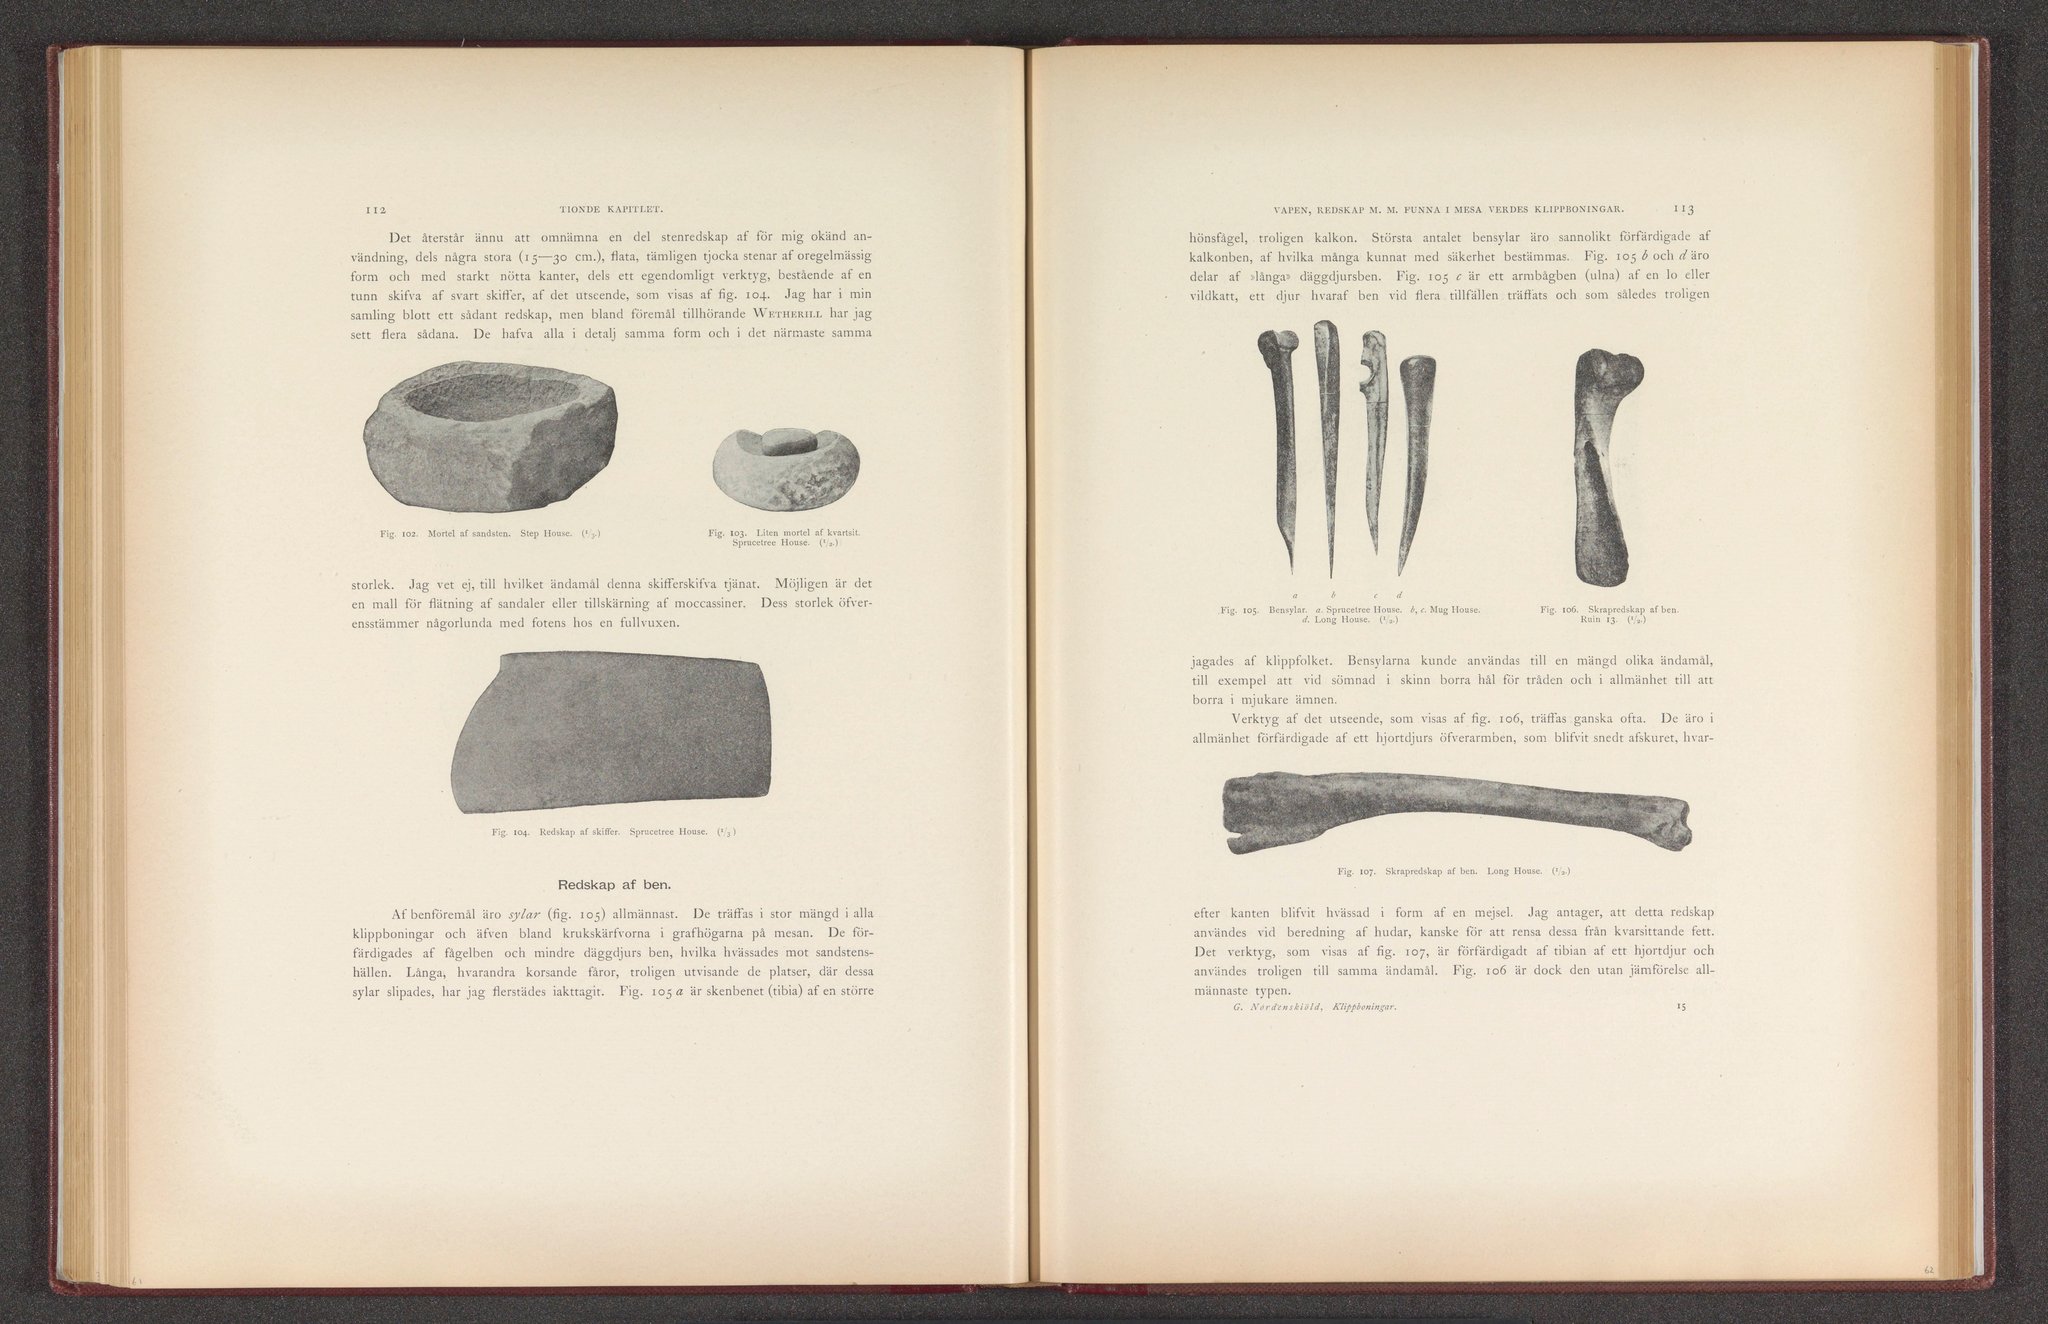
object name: photomechanical print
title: Twee vijzels en een stuk gereedschap die zijn gevonden in het Mesa Verde National Park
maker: gustaf nordenskiöld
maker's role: fotograaf, schrijver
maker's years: 1868-1895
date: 1891-1893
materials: paper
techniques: autotype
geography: vienna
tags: pestle and mortar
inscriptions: number: ‘Fig. 102. Fig. 103. Fig. 104.’